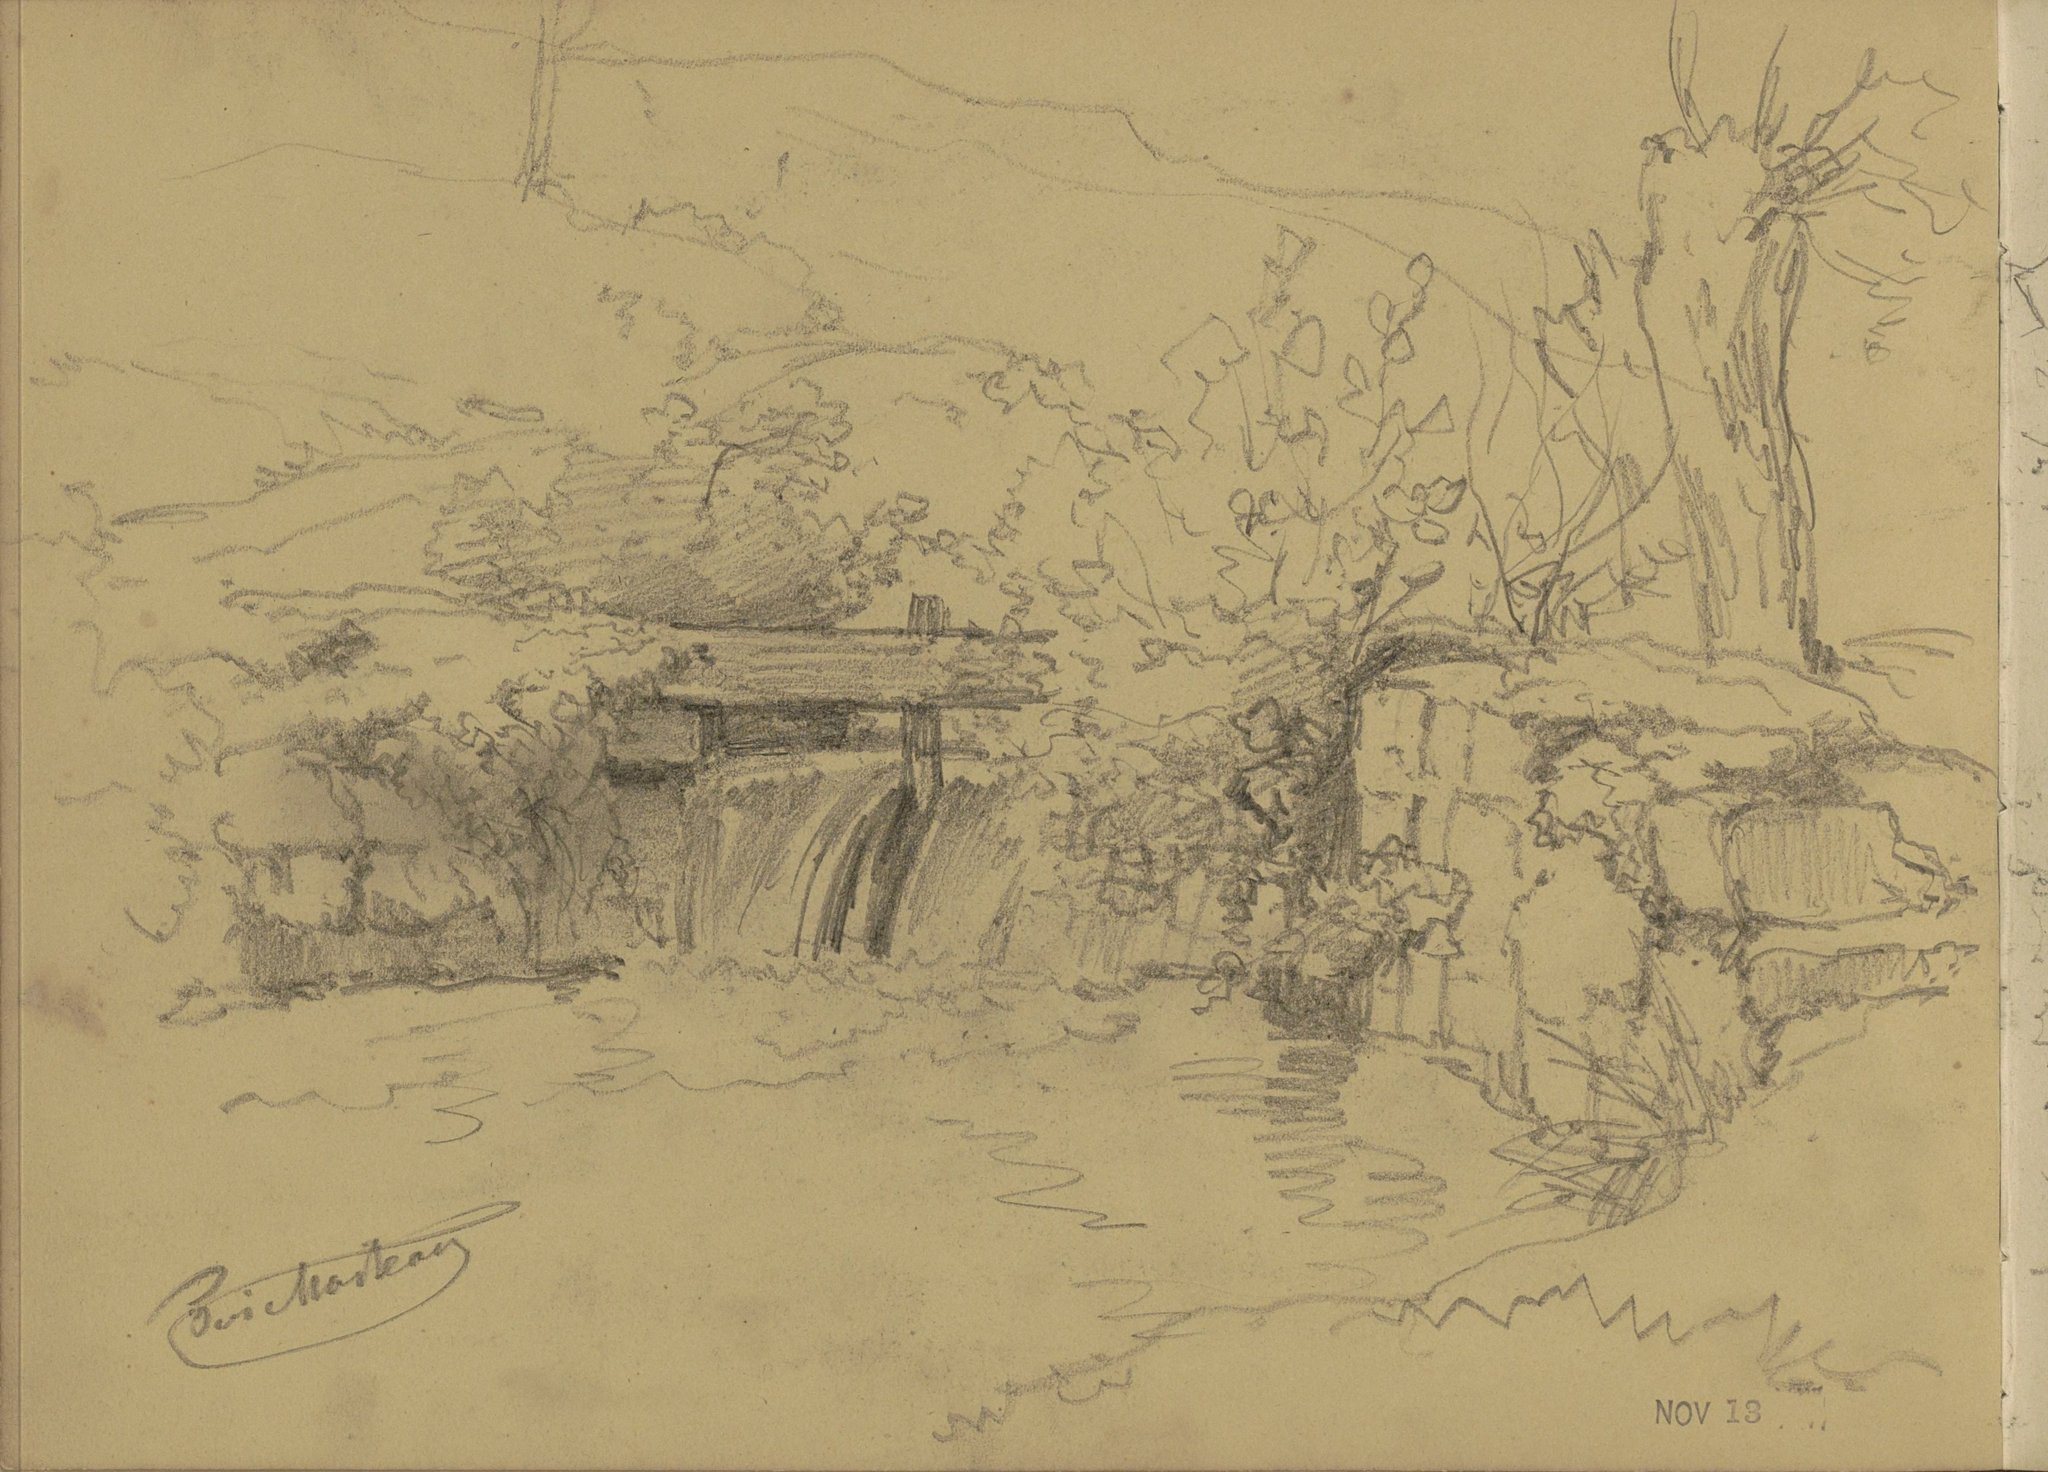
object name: sketchbook leaf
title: Beek met waterval bij Bois Marteau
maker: willem roelofs (i)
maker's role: draughtsman, painter, print maker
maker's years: 1822-1897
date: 1851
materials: paper, pencil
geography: marteau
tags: landscapes, waterfall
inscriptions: date: ‘NOV 13 , ,,’, annotation: ‘Bois Marteau’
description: Blad 7 verso uit een schetsboek met 25 bladen.